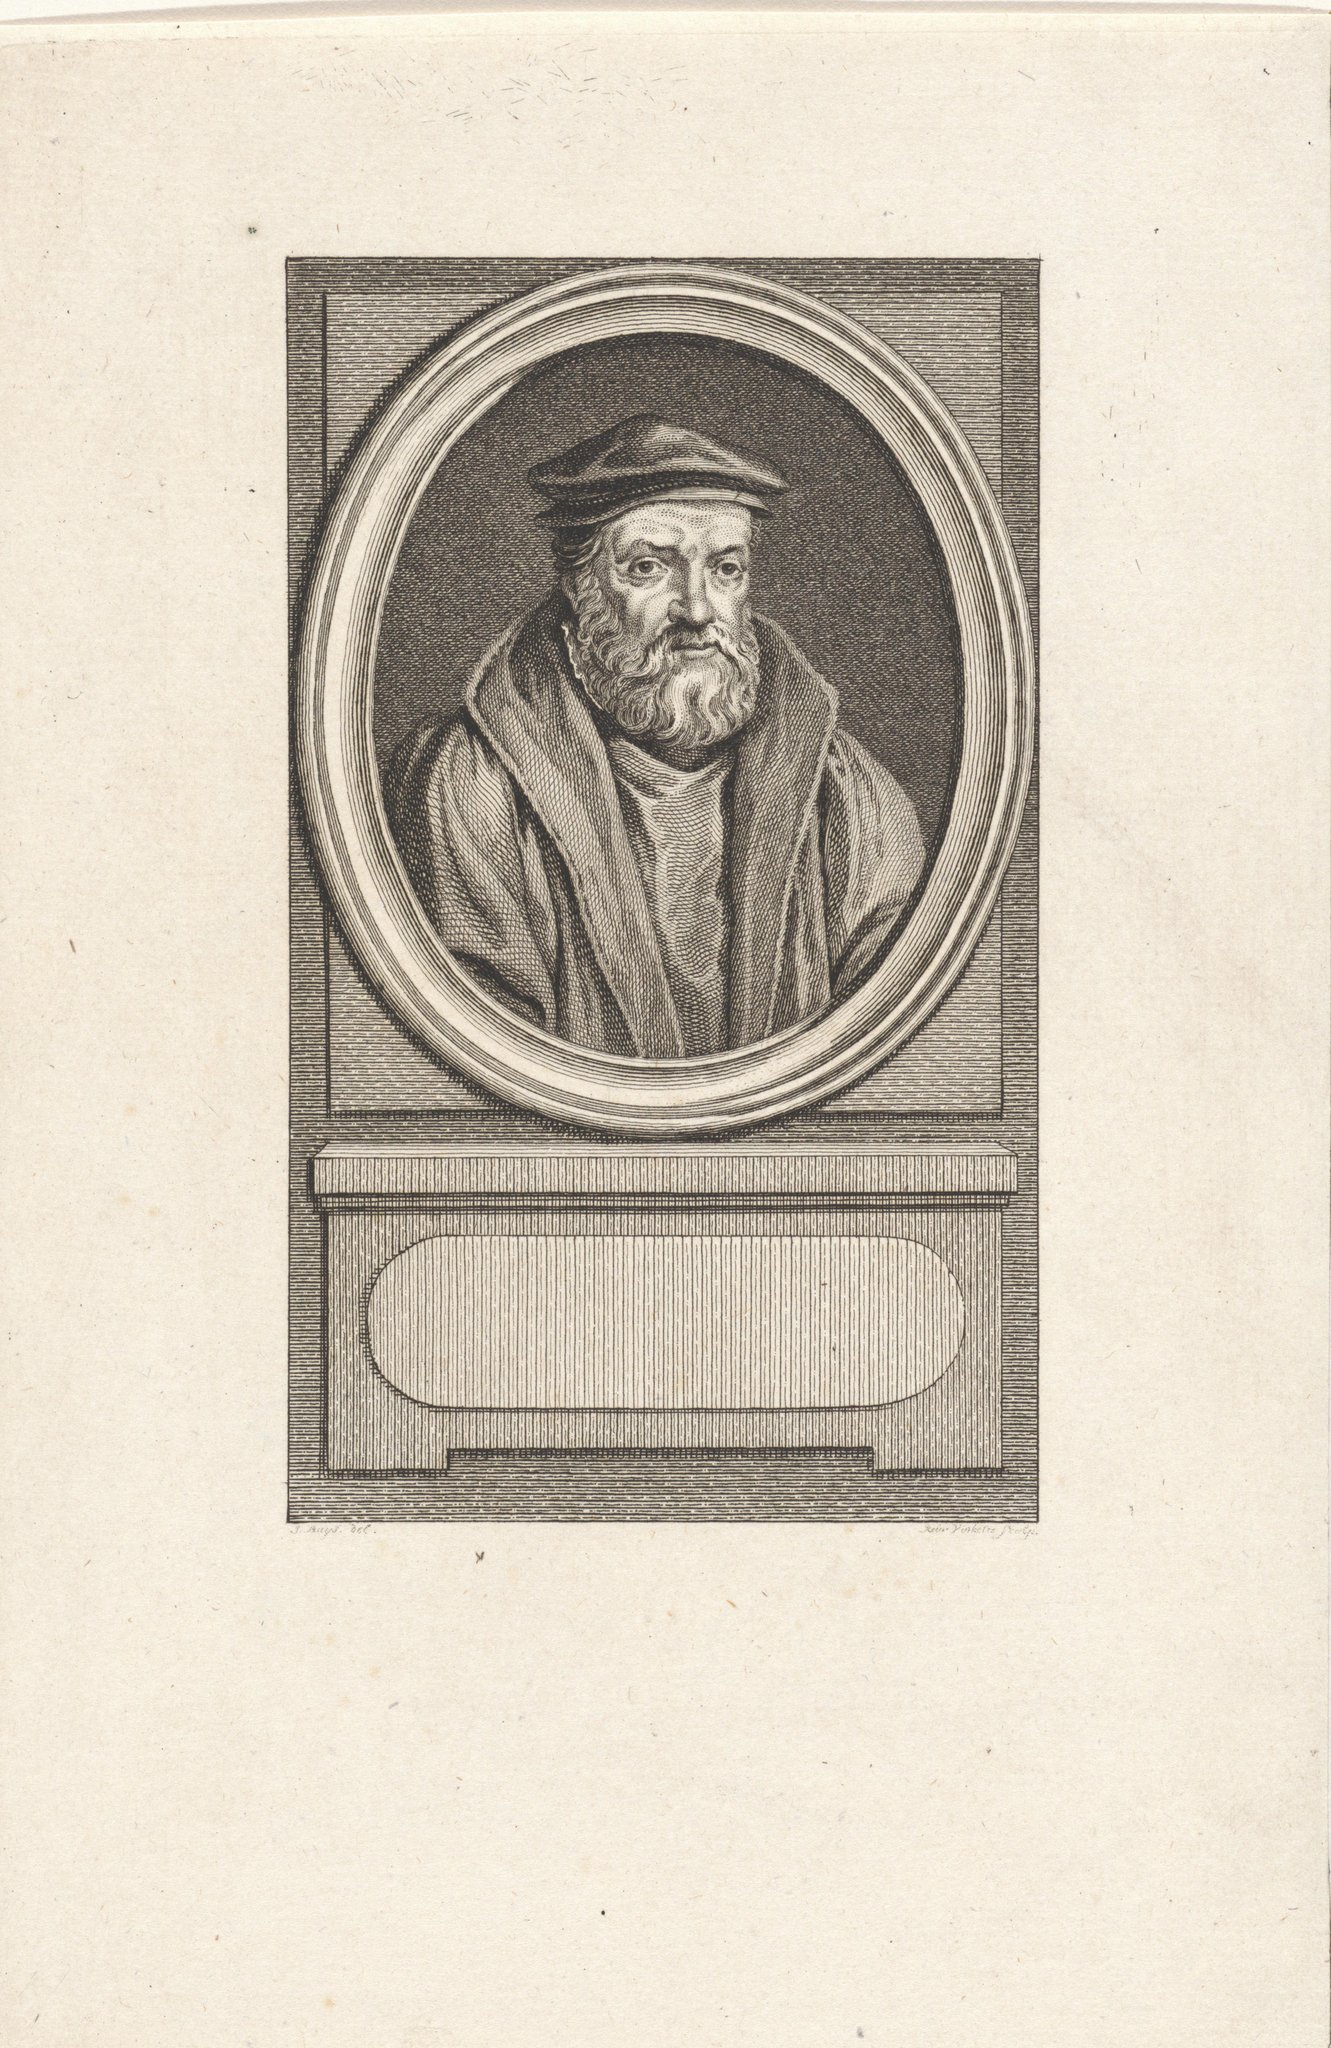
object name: print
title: Portret van Johannes Sartorius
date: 1792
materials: paper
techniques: engraving, etching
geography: amsterdam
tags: amsterdam, johannes sartorius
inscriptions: collector's mark: Lugt 2228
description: Latere staat prent gebruikt als boekillustratie in: Kok, Jacobus. Vaderlandsch woordenboek : met kaarten, plaaten en pourtraitten. Amsterdam: Johannes Allart, 1785-1796. Deel XXVI.